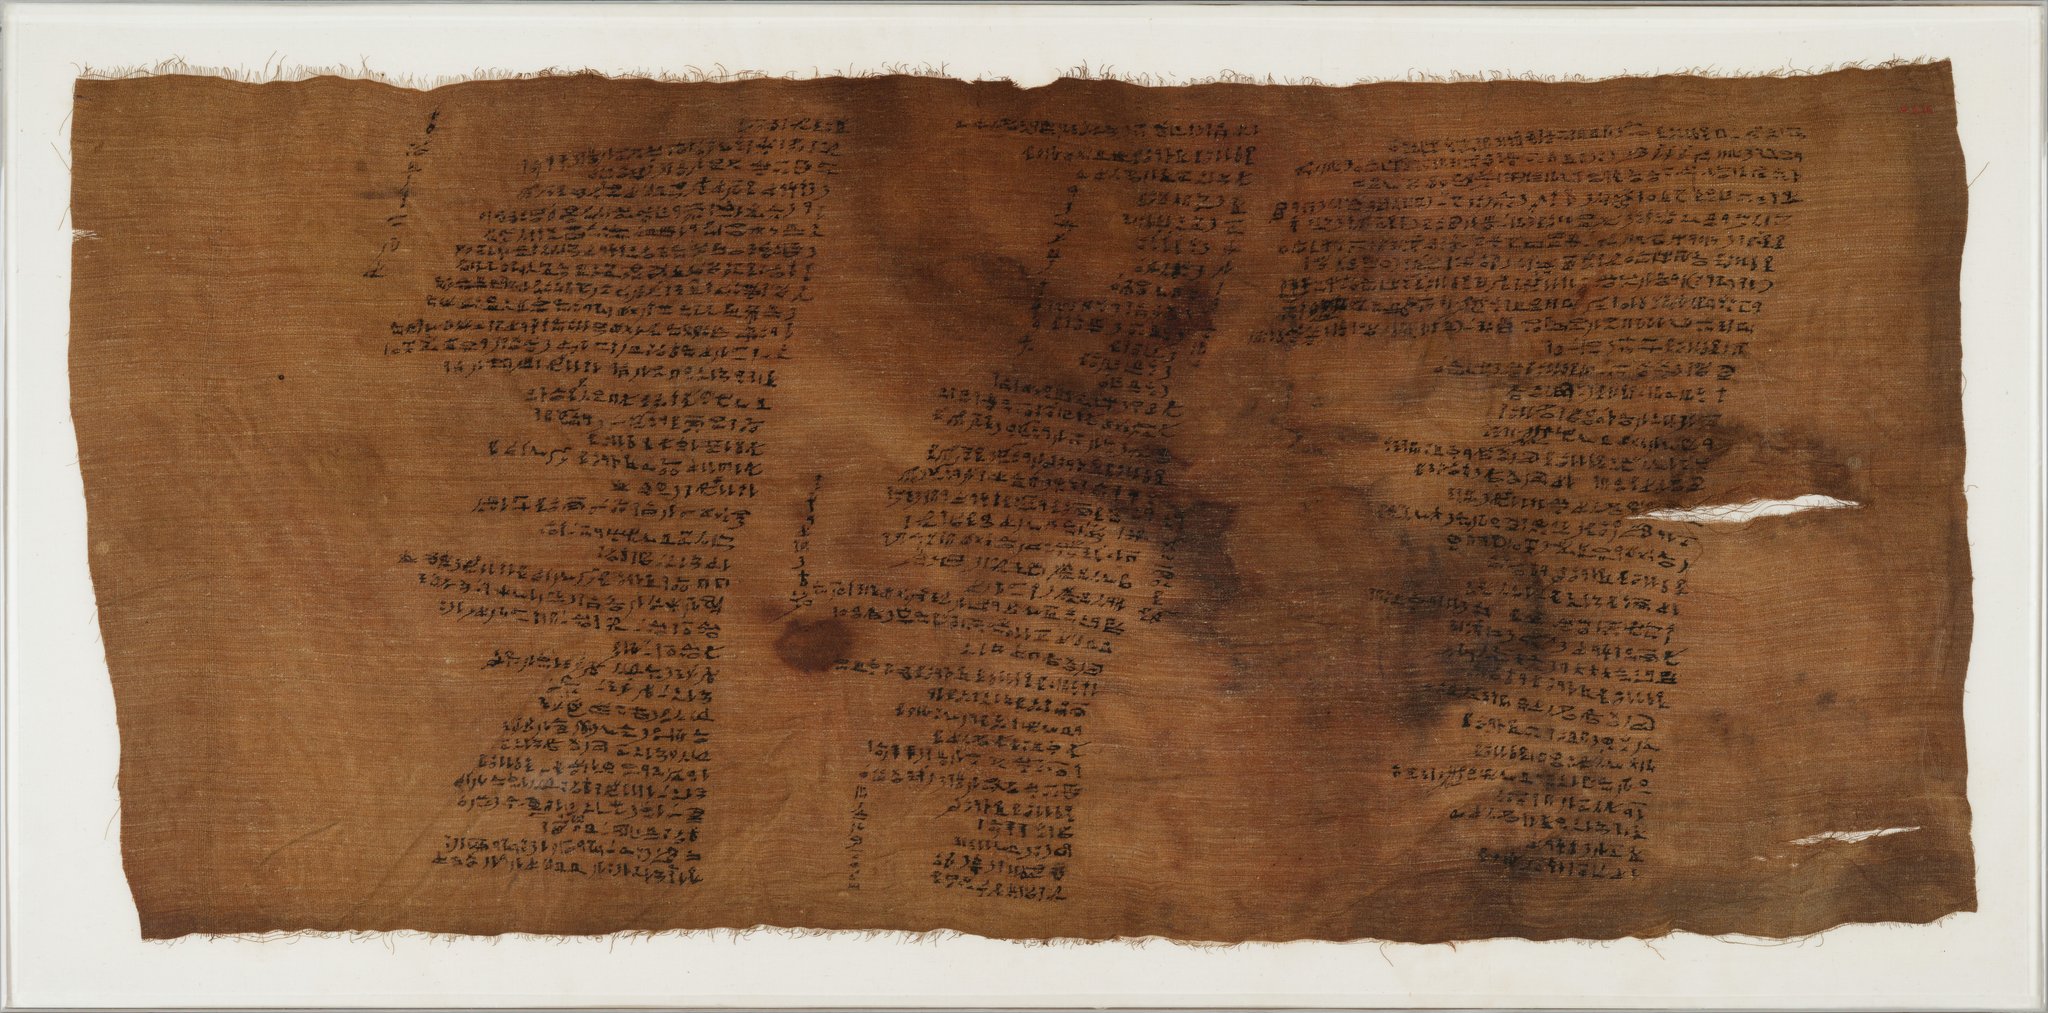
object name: linen, satiyet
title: Inscribed Linen of Satiyet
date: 332-330 BCE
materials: linen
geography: egypt